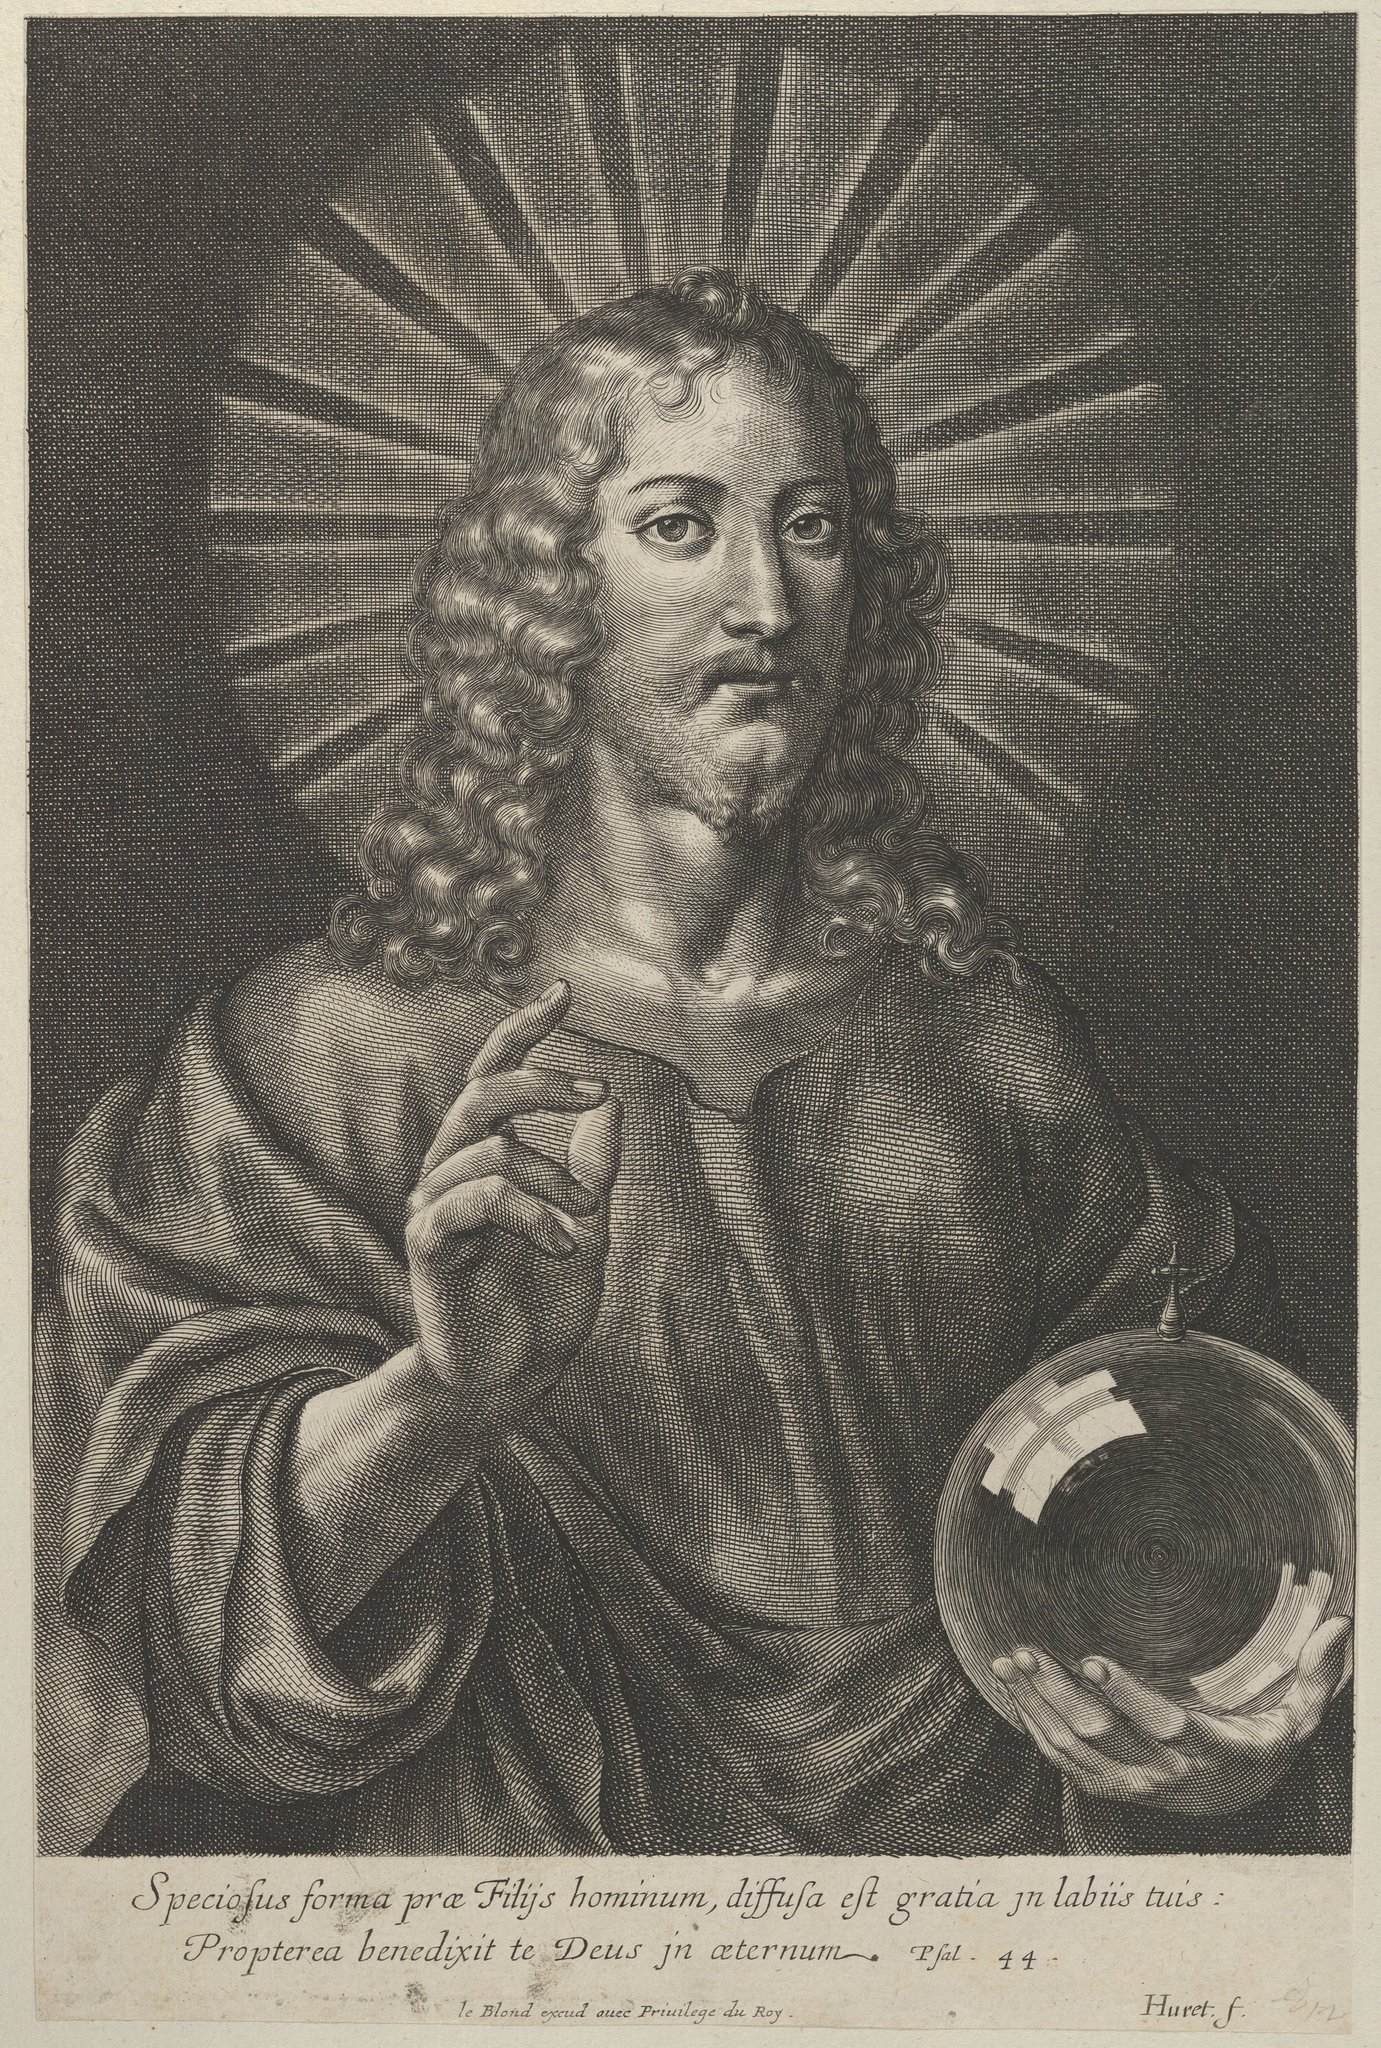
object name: print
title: The Savior with the Globe in his Hand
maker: grégoire huret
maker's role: artist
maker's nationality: french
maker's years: 1606-1670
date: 1601-1700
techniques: engraving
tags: jesus,globes